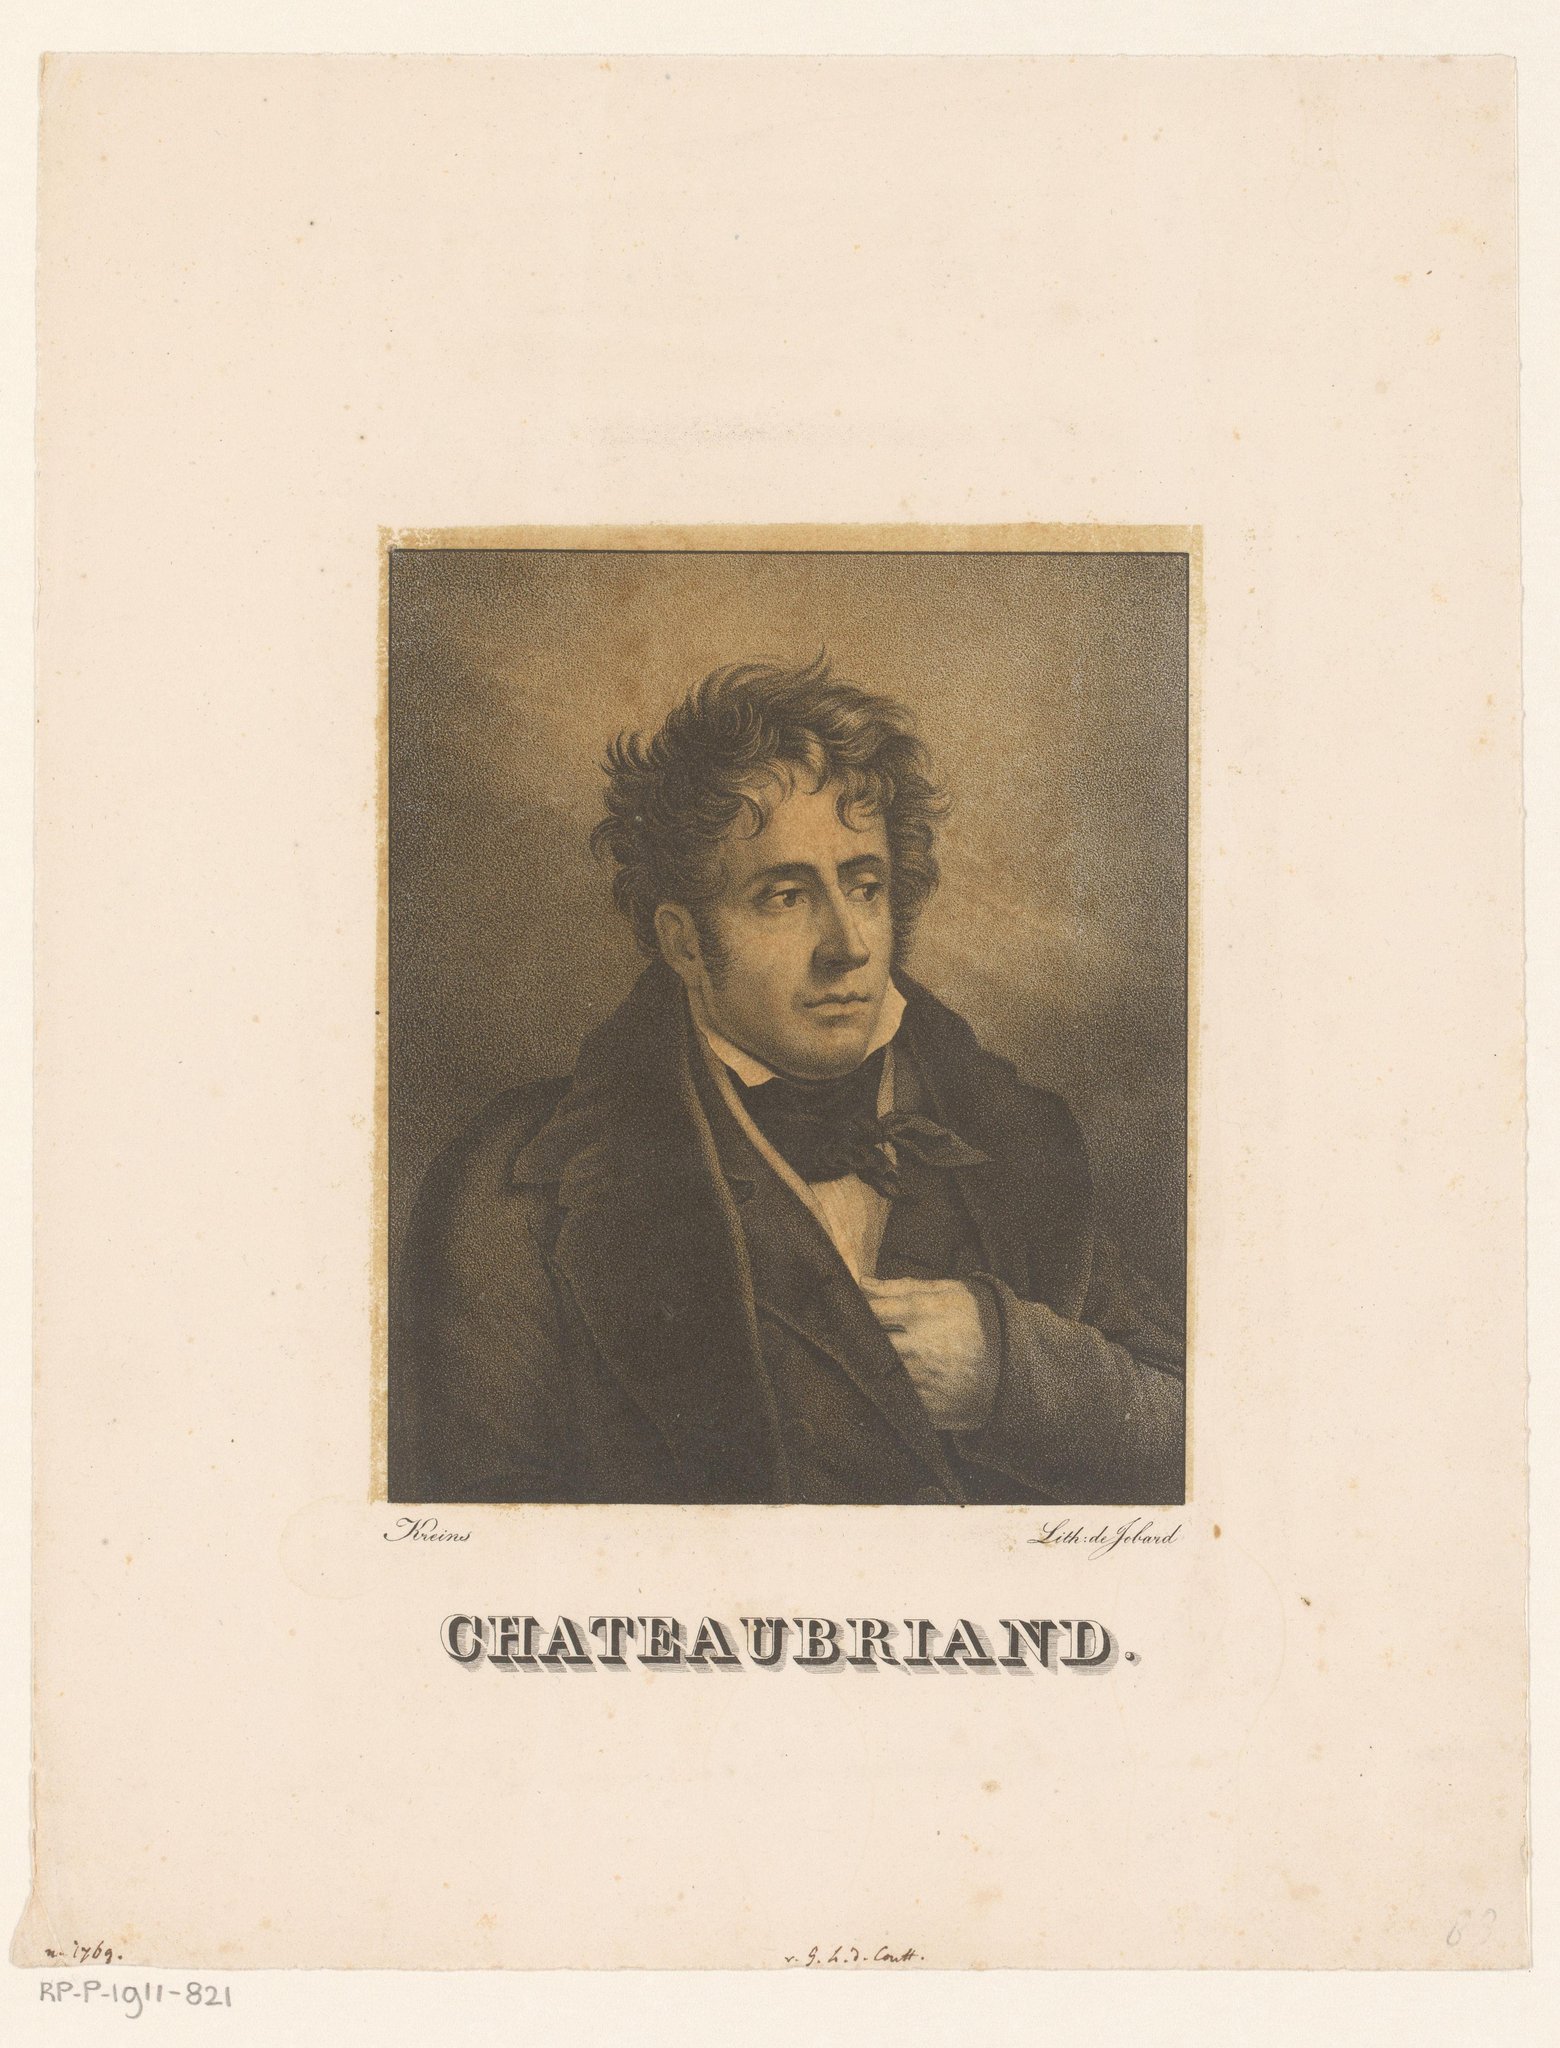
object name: print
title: Portret van François-René de Chateaubriand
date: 1816-1862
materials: paper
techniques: tone lithography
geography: brussels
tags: paris, politician, françois-rené de chateaubriand, historical persons, portrait of a writer, writer, poet, author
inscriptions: collector's mark: Lugt 2228